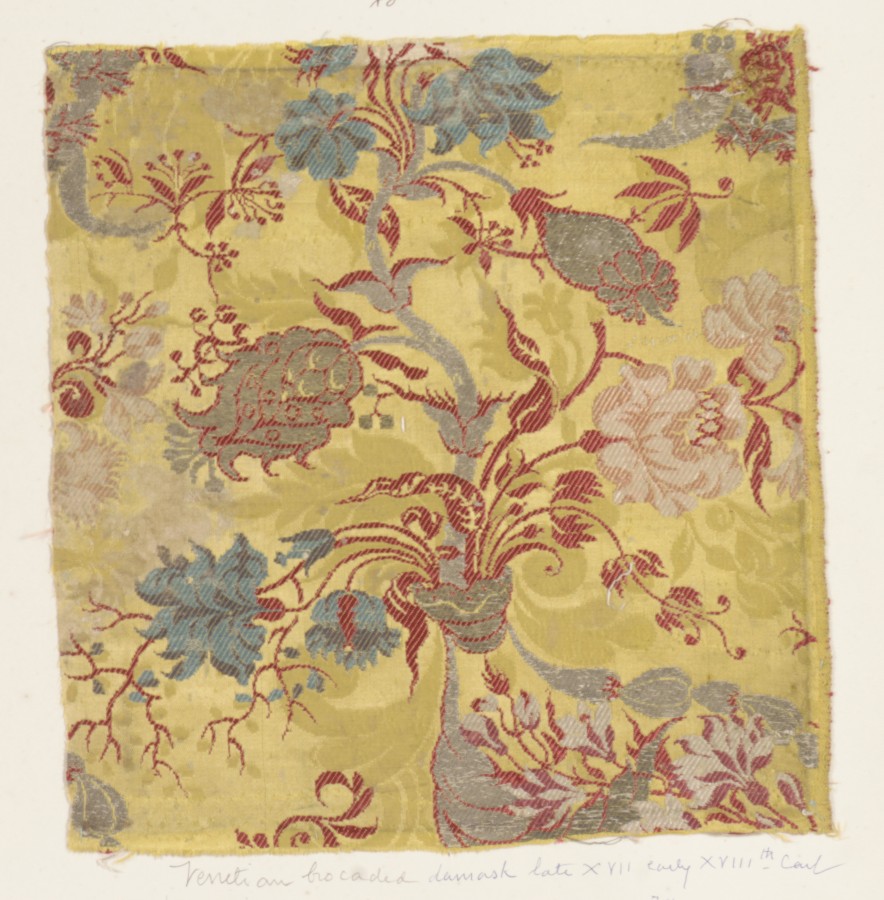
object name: fragment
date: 1701-1733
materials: metal thread, silk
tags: flowers,leaves